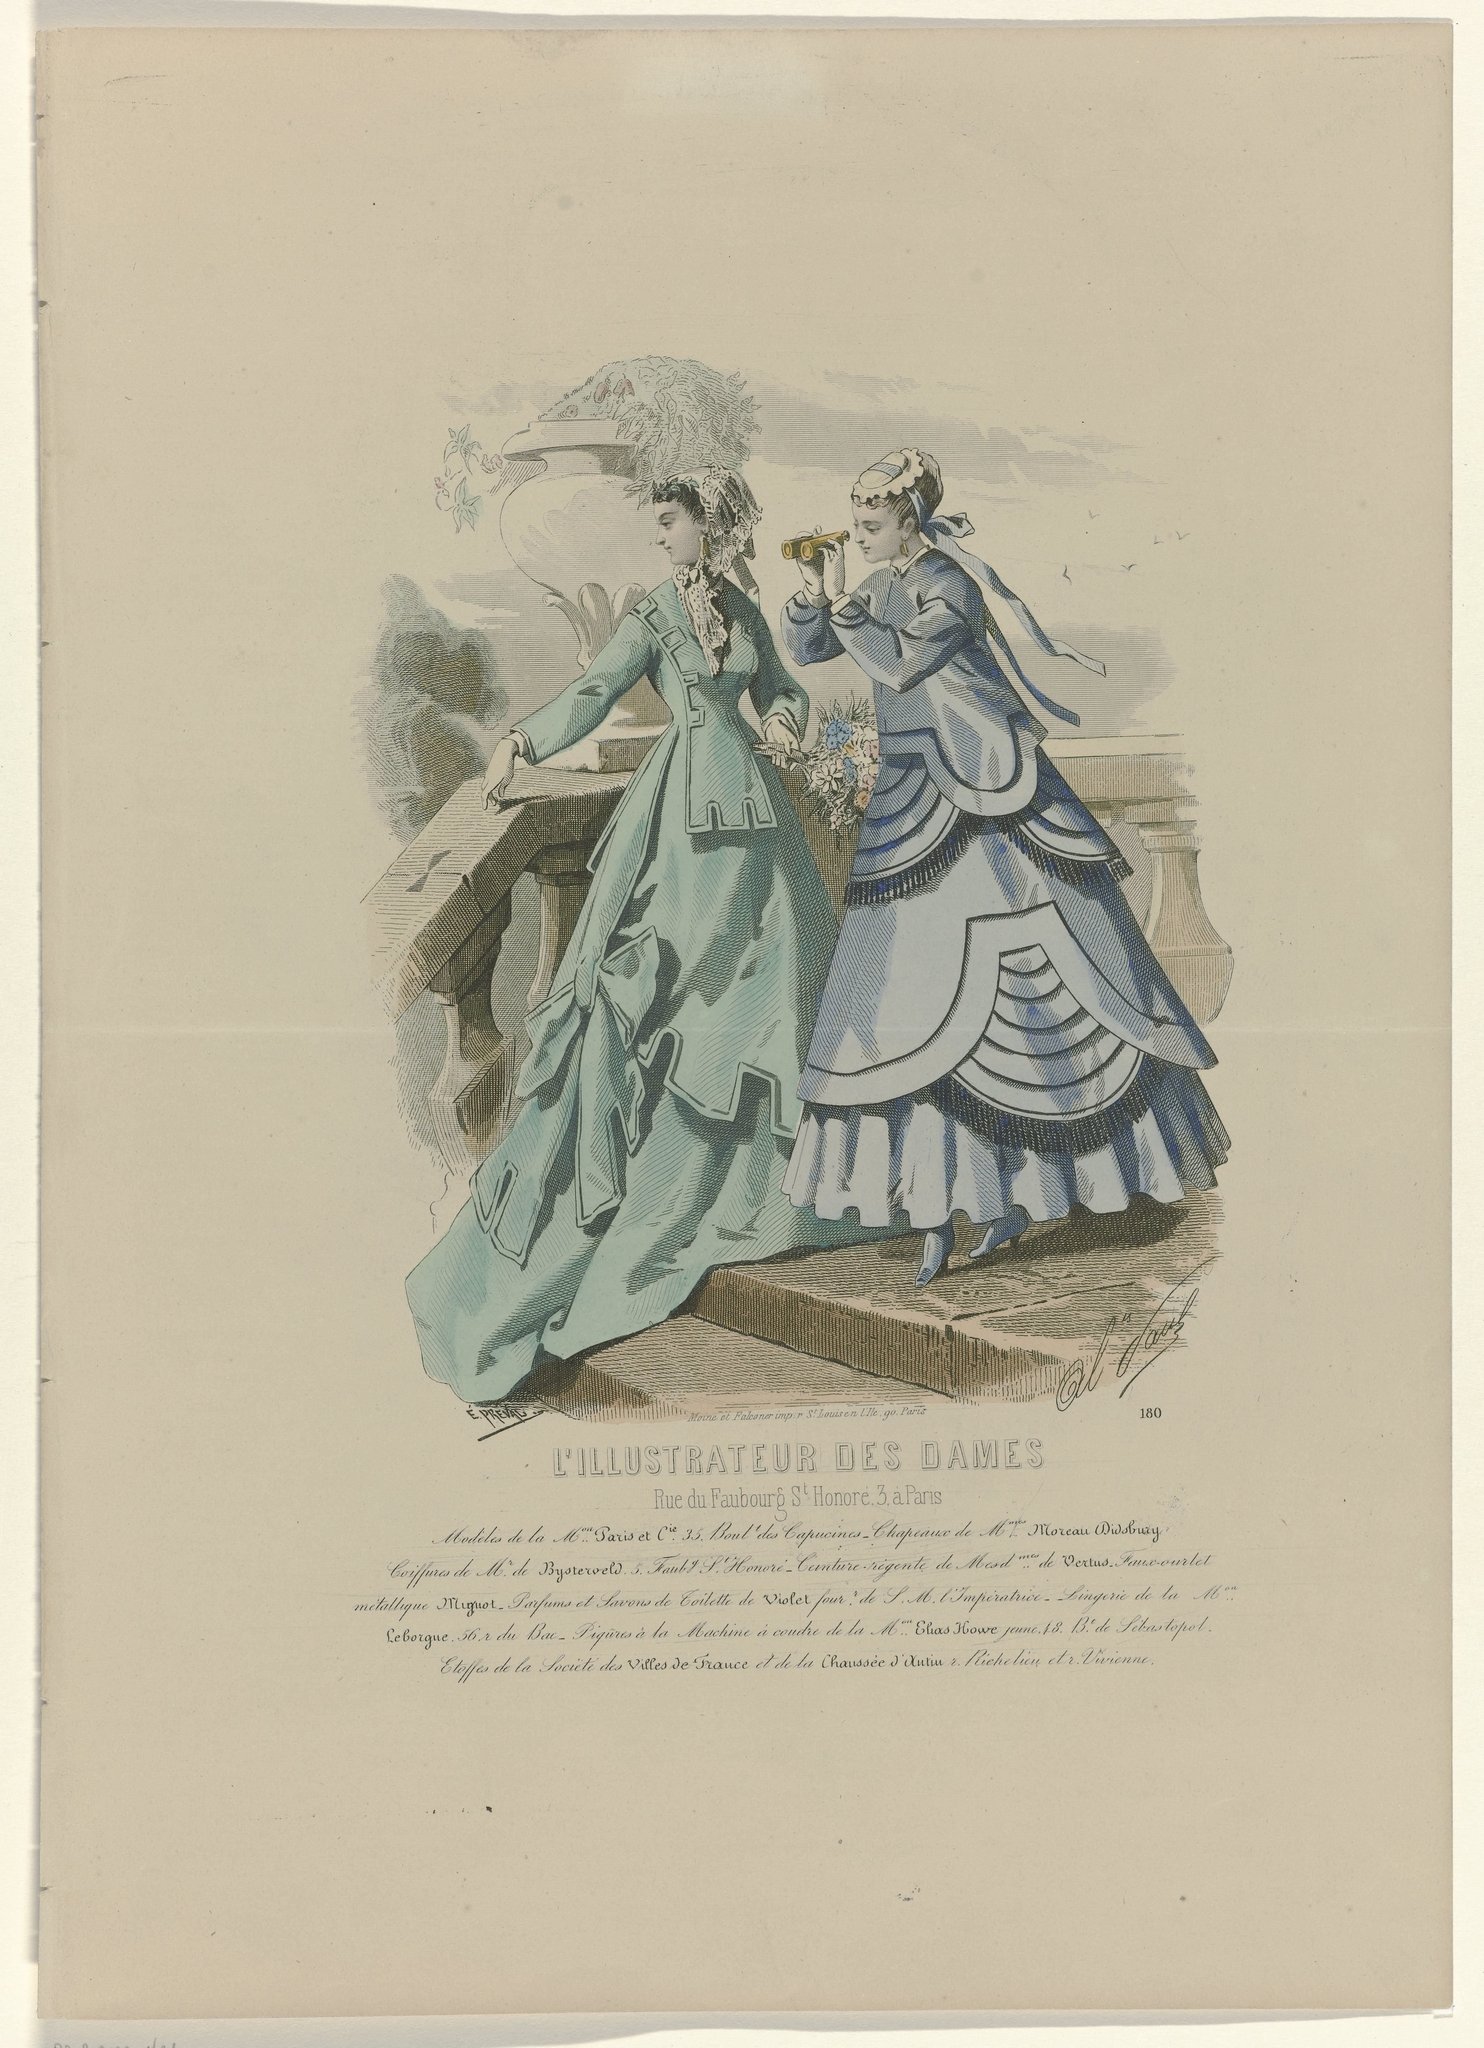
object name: fashion print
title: L'Illustrateur des Dames, 1865, No. 180 : Modèles de la Mon. Paris et ci (...)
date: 1865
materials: paper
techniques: hand coloring, engraving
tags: clothing for the upper part of the body (+ women's clothes), cut flowers; nosegay, bunch of flowers, styles of hairdress - aa - ~ women, fashion plates, head-gear: hat (+ women's clothes), skirt (+ women's clothes), balustrade, binoculars, spy-glass, etc.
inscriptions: title: ‘L'Illustrateur des Dames’, caption: ‘Modèles de la Mon. Paris et Cie. 35. Boul 'des Capucines_Chapeaux de Mmes. Moreau Didsbury. Coiffures de Mr. de Bysterveld. 5. Faubg. St. Honoré_Ceinture-régente de Mesdmes. de Vertus. Faux-ourlet métallique Miguot_Parfums et Savons de Toilette de Violet fourr. de S.M. l Ímpératrice_ lingerie de la Mon. Leborgue.56 r. du Bac_piqures à la Machine à coudre de la Mon. Elias Howe jeune 48. Bt. de Sebastopol. etoffes de la Societè des Villes de France et de la Chaussée d'Antin r. Richelieu et r. Vivienne.’, address: ‘Rue du faubourg S.t Honoré 3 à Paris’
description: Twee vrouwen staan buiten bovenaan een trap. Één van hen kijkt door een verrekijker. Onder de voorstelling enkele regels reclametekst voor verschillende producten. Prent uit het modetijdschrift L'Illustrateur des Dames (1861-1874).